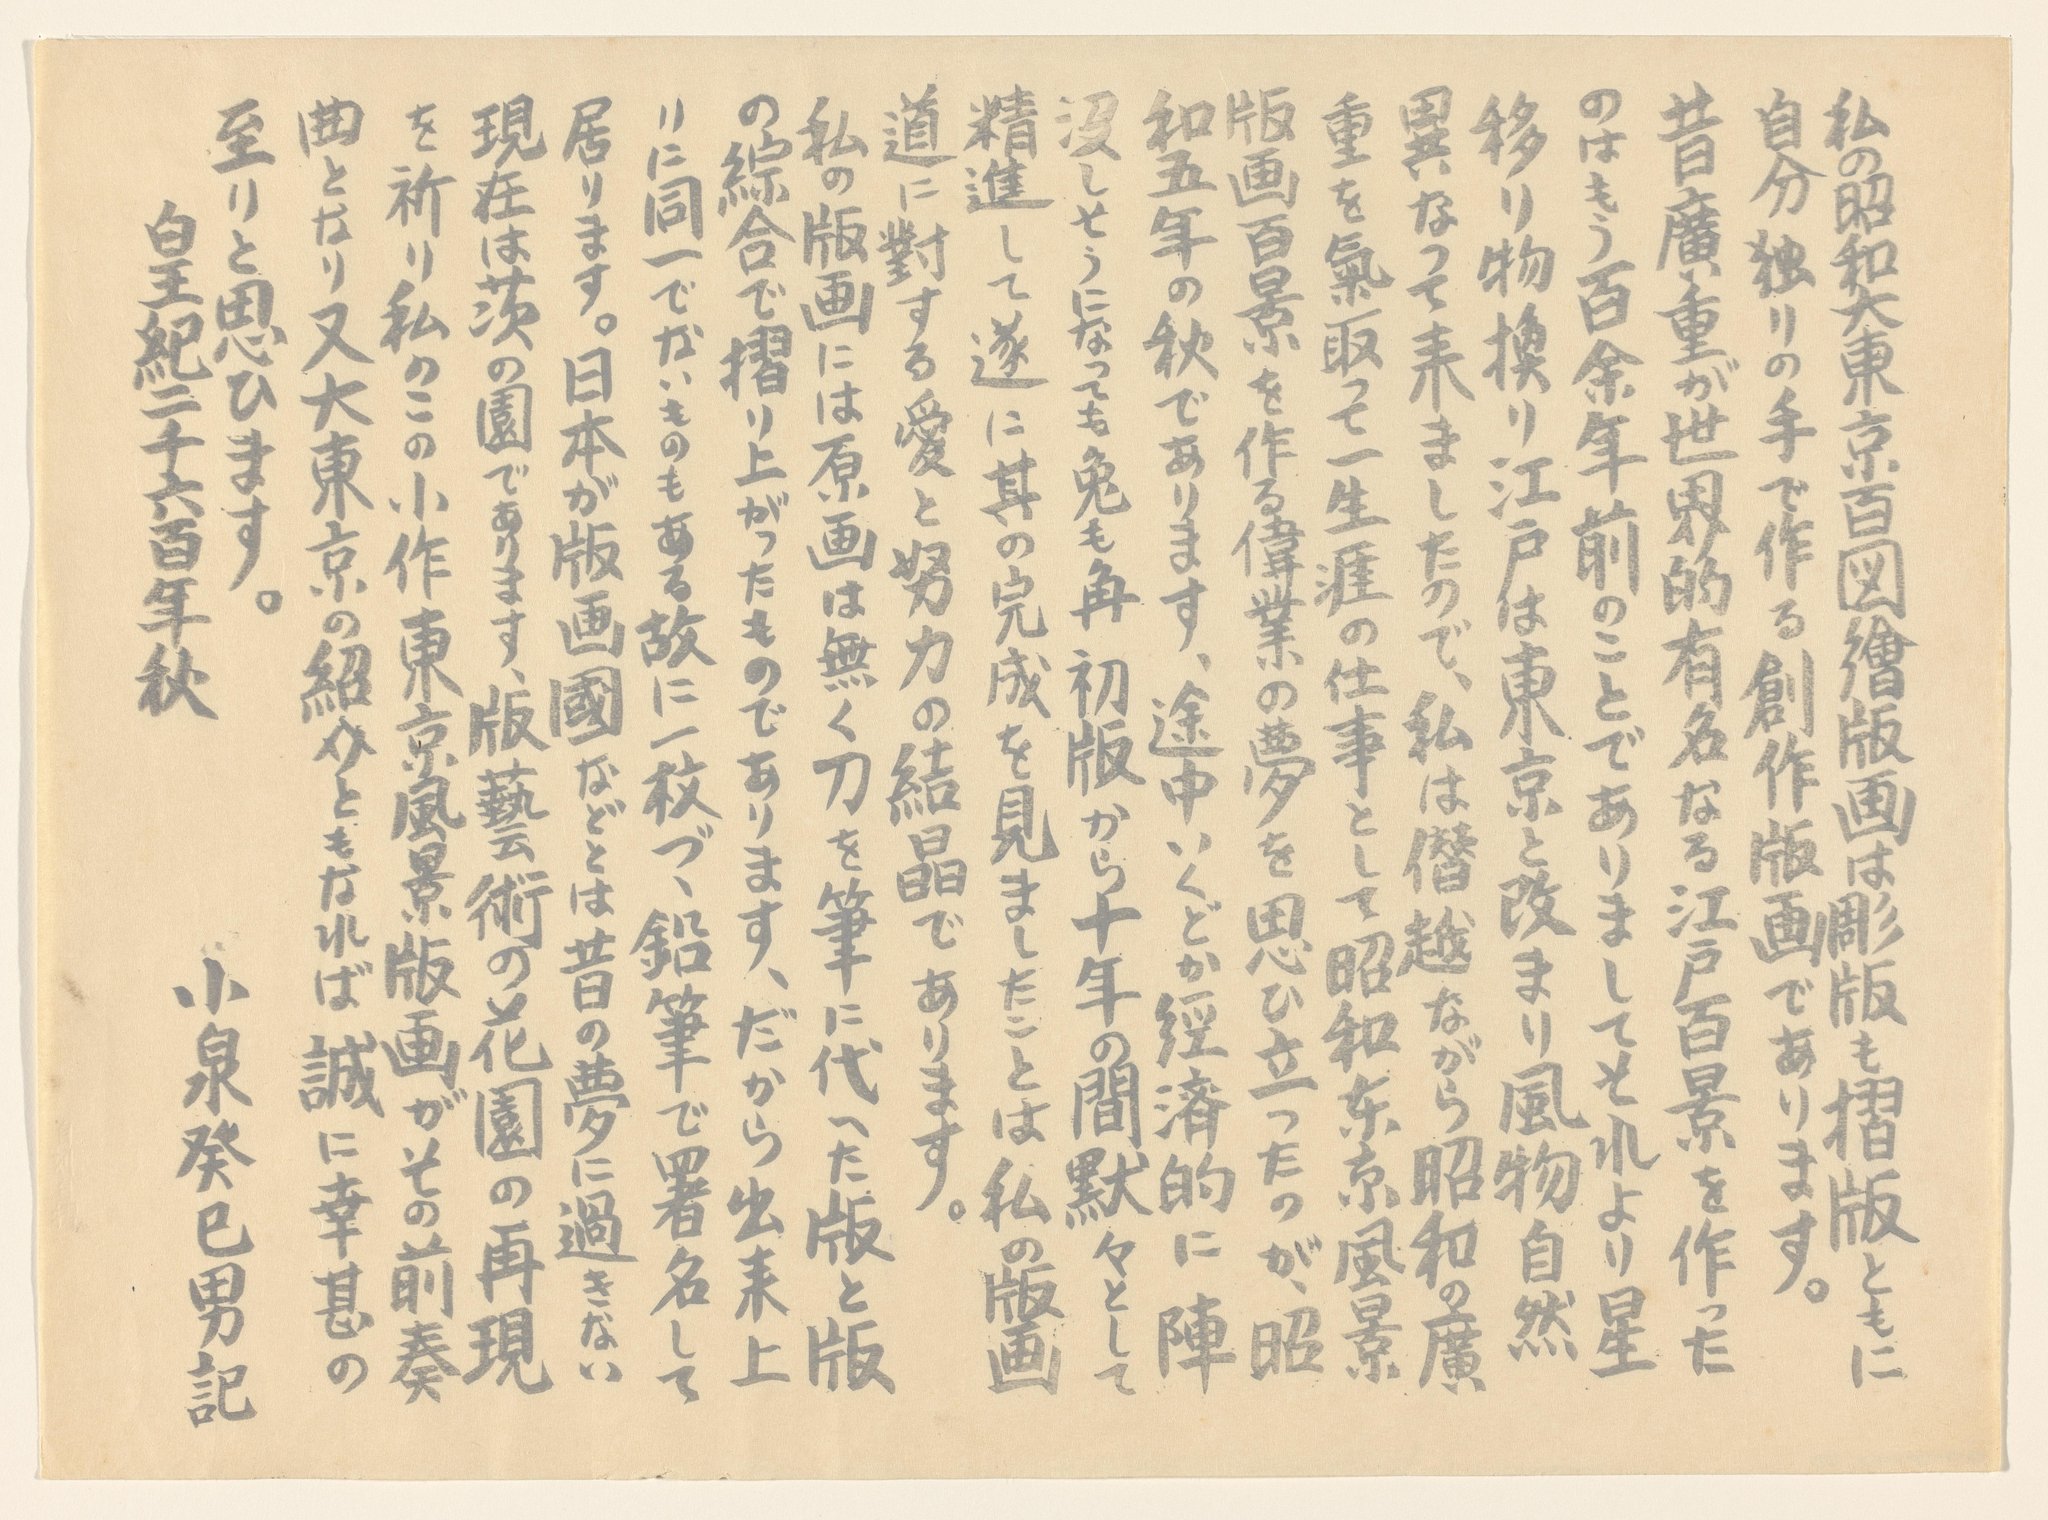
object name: print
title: One hundred pictures of Great Tokyo in the Shōwa era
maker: koizumi kishio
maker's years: 1893-1945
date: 1940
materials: paper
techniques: woodcut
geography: japan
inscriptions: tekst, gedrukt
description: In september 1928 begon Koizumi Kishio aan zijn ambitieuze plan om honderd landschapsprenten met scènes in Tokyo volledig zelf te ontwerpen, hiervan zelf de drukblokken te snijden en zelf de prenten te drukken. De aanleiding voor het project was grote verandering die Tokyo onderging door de verwoestende Grote Kantō-aardbeving van 1923 en de wederopbouw die daarop volgde. Kishio maakt een bewuste verwijzing naar de bekende serie ‘Honderd beroemde gezichten op Edo’ door Utagawa Hiroshige (1797–1858), met prenten van locaties in Edo—de oude benaming voor Tokyo. Kishio toont overwegend moderne gebouwen, instituten en mensen die de tijdsgeest van de jaren 1920 en 1930 weerspiegelen. Sommige prenten onthullen daarentegen een nostalgische blik op overblijfselen uit het oude Edo. Kishio verkocht de prenten aan de hand van een abonnement met een limiet van vijftig leden, die elke maand een of twee prenten zouden ontvangen. Het project begon met negen abonnementen, maar al na de tweede maand werden meerdere daarvan opgezegd en slechts vier mecenassen bleven lid tot en met de voltooiing van de serie. Hij bracht het honderdste ontwerp uit in 1937. Zijn leermeester Ishii Hakutei schreef een inleiding in 1938 die Kishio verwerkte tot een prent en toevoegde aan de set. Tussen 1939 en 1940 maakte hij nog eens negen extra ontwerpen. Met acht van deze ontwerpen verving hij oudere nummers uit de serie, mogelijk omdat hij niet tevreden was met de composities. Uiteindelijk lukte het Kishio om tien complete sets te verkopen aan de shin hanga-uitgever Watanabe Shōzaburō en liet hiervoor speciale houten dozen maken. Deze prent behoort tot een van die tien sets.